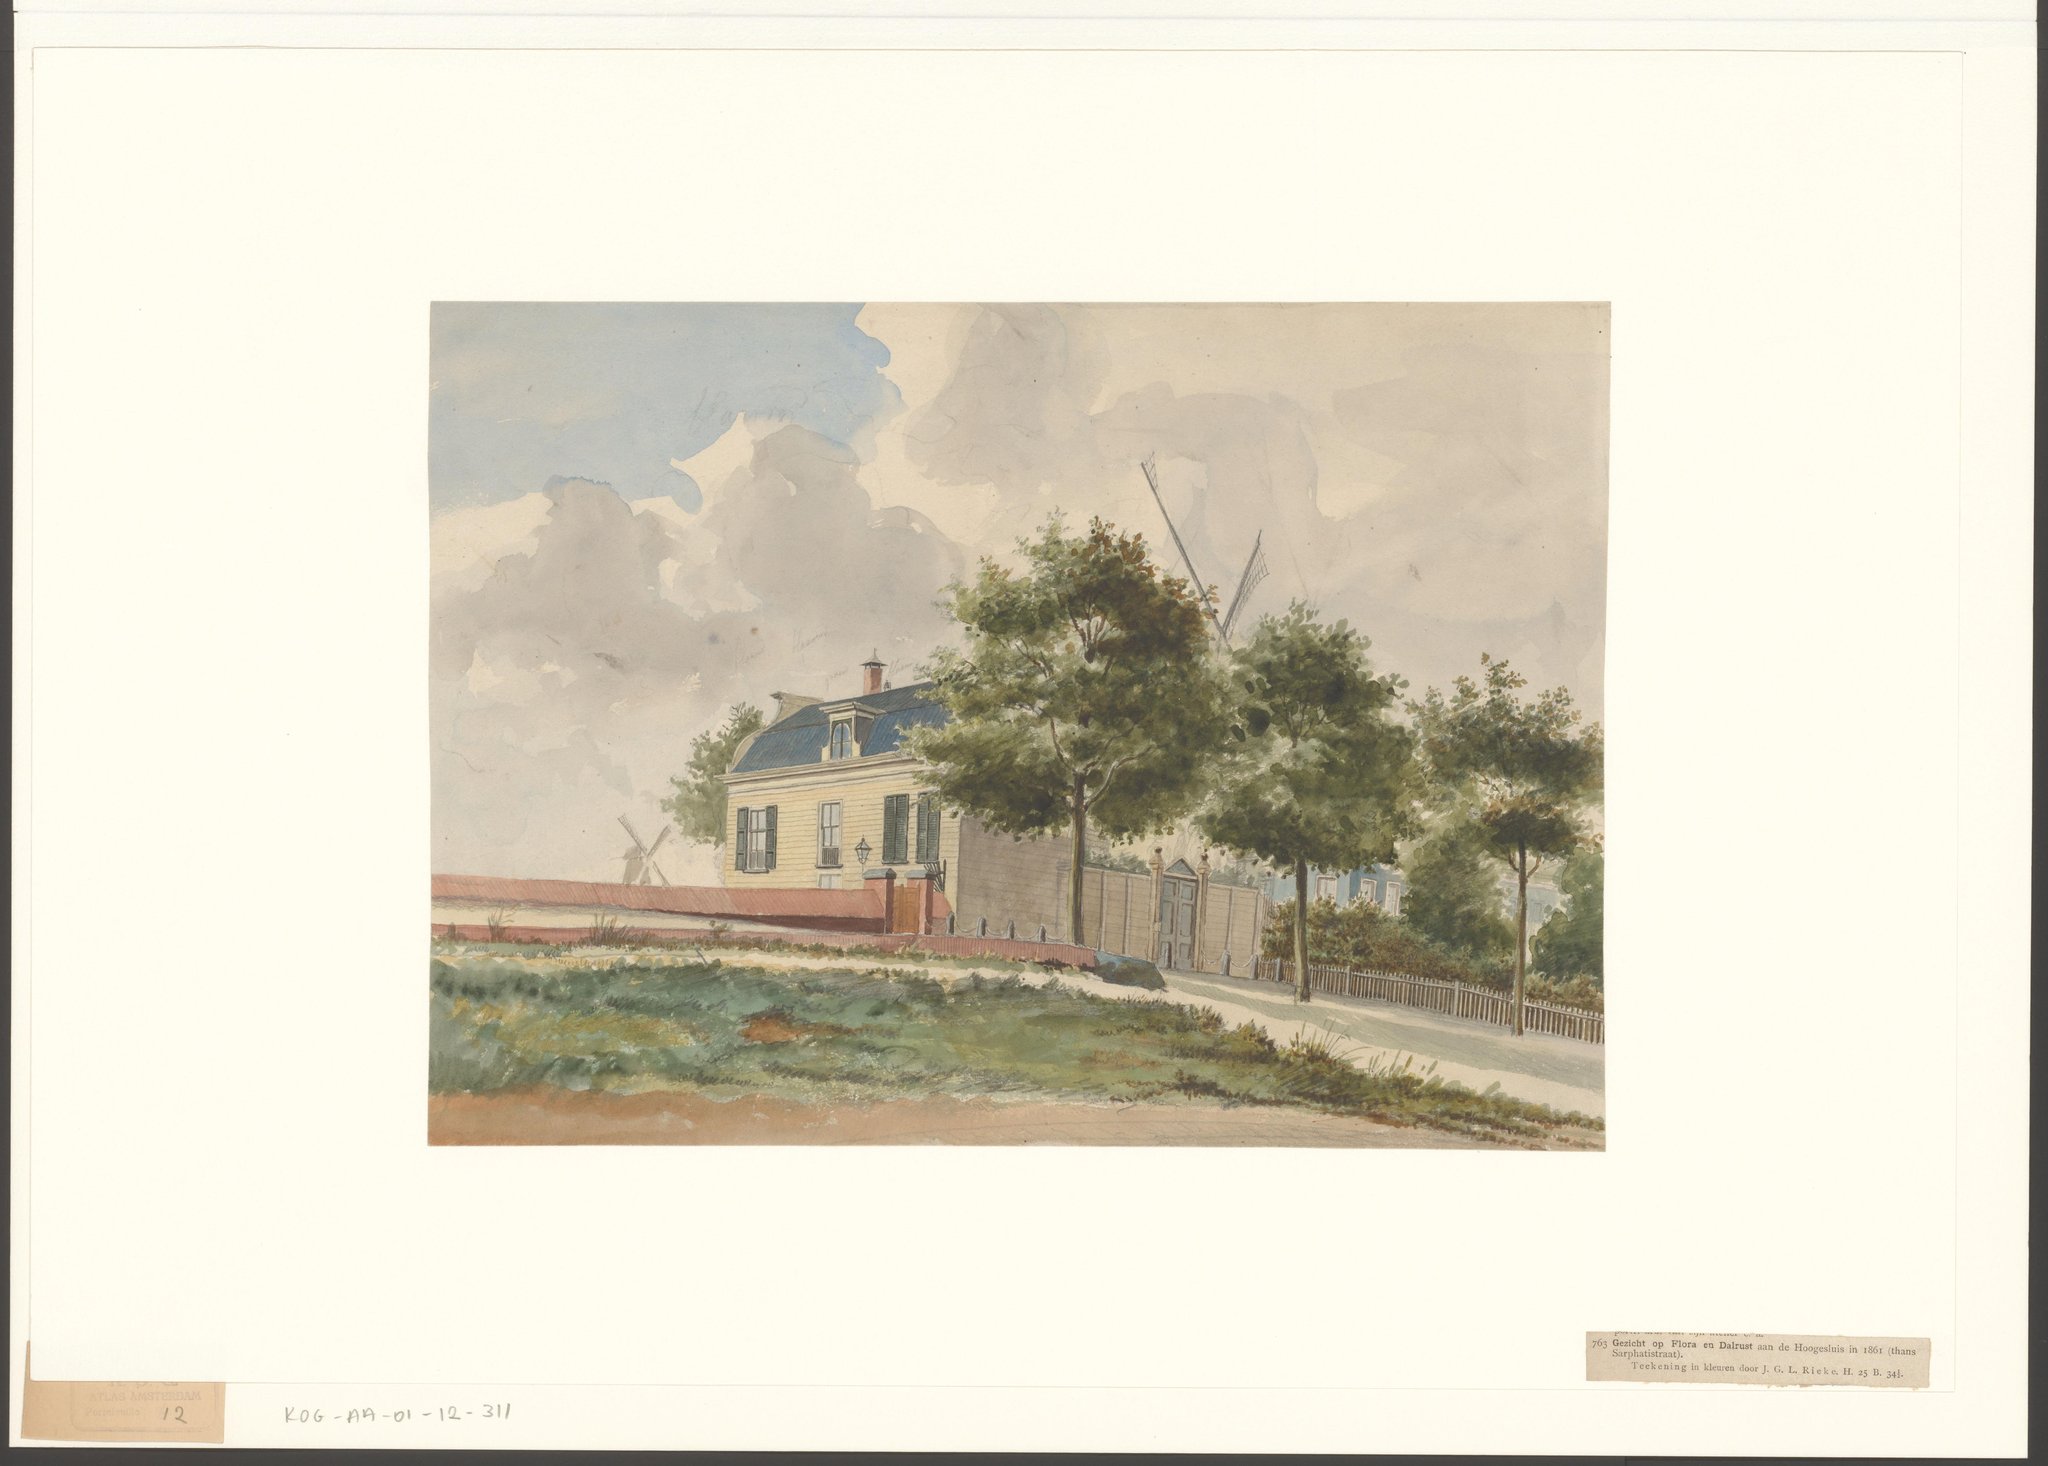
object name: drawing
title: Gezicht op Flora en Dalrust langs de Sarphatistraat bij de Hoge Sluis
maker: johan george lodewijk rieke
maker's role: draughtsman, print maker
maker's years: 1817-1898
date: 1861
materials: paper, pencil, watercolor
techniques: brush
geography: amsterdam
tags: city-view in general; 'veduta', road, path, farm or solitary house in landscape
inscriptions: inscription: ‘Port. 12 - 311’, collector's mark: ‘12’ Lugt 1641b, inscription: ‘763 Gezicht op (...) 25 B. 34 1/2’, inscription: ‘Gezicht op Flora (...) Rieke in 1861’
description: Onderwerpsrubriek binnen de Atlas Amsterdam: Sarphatistraat, Schans.